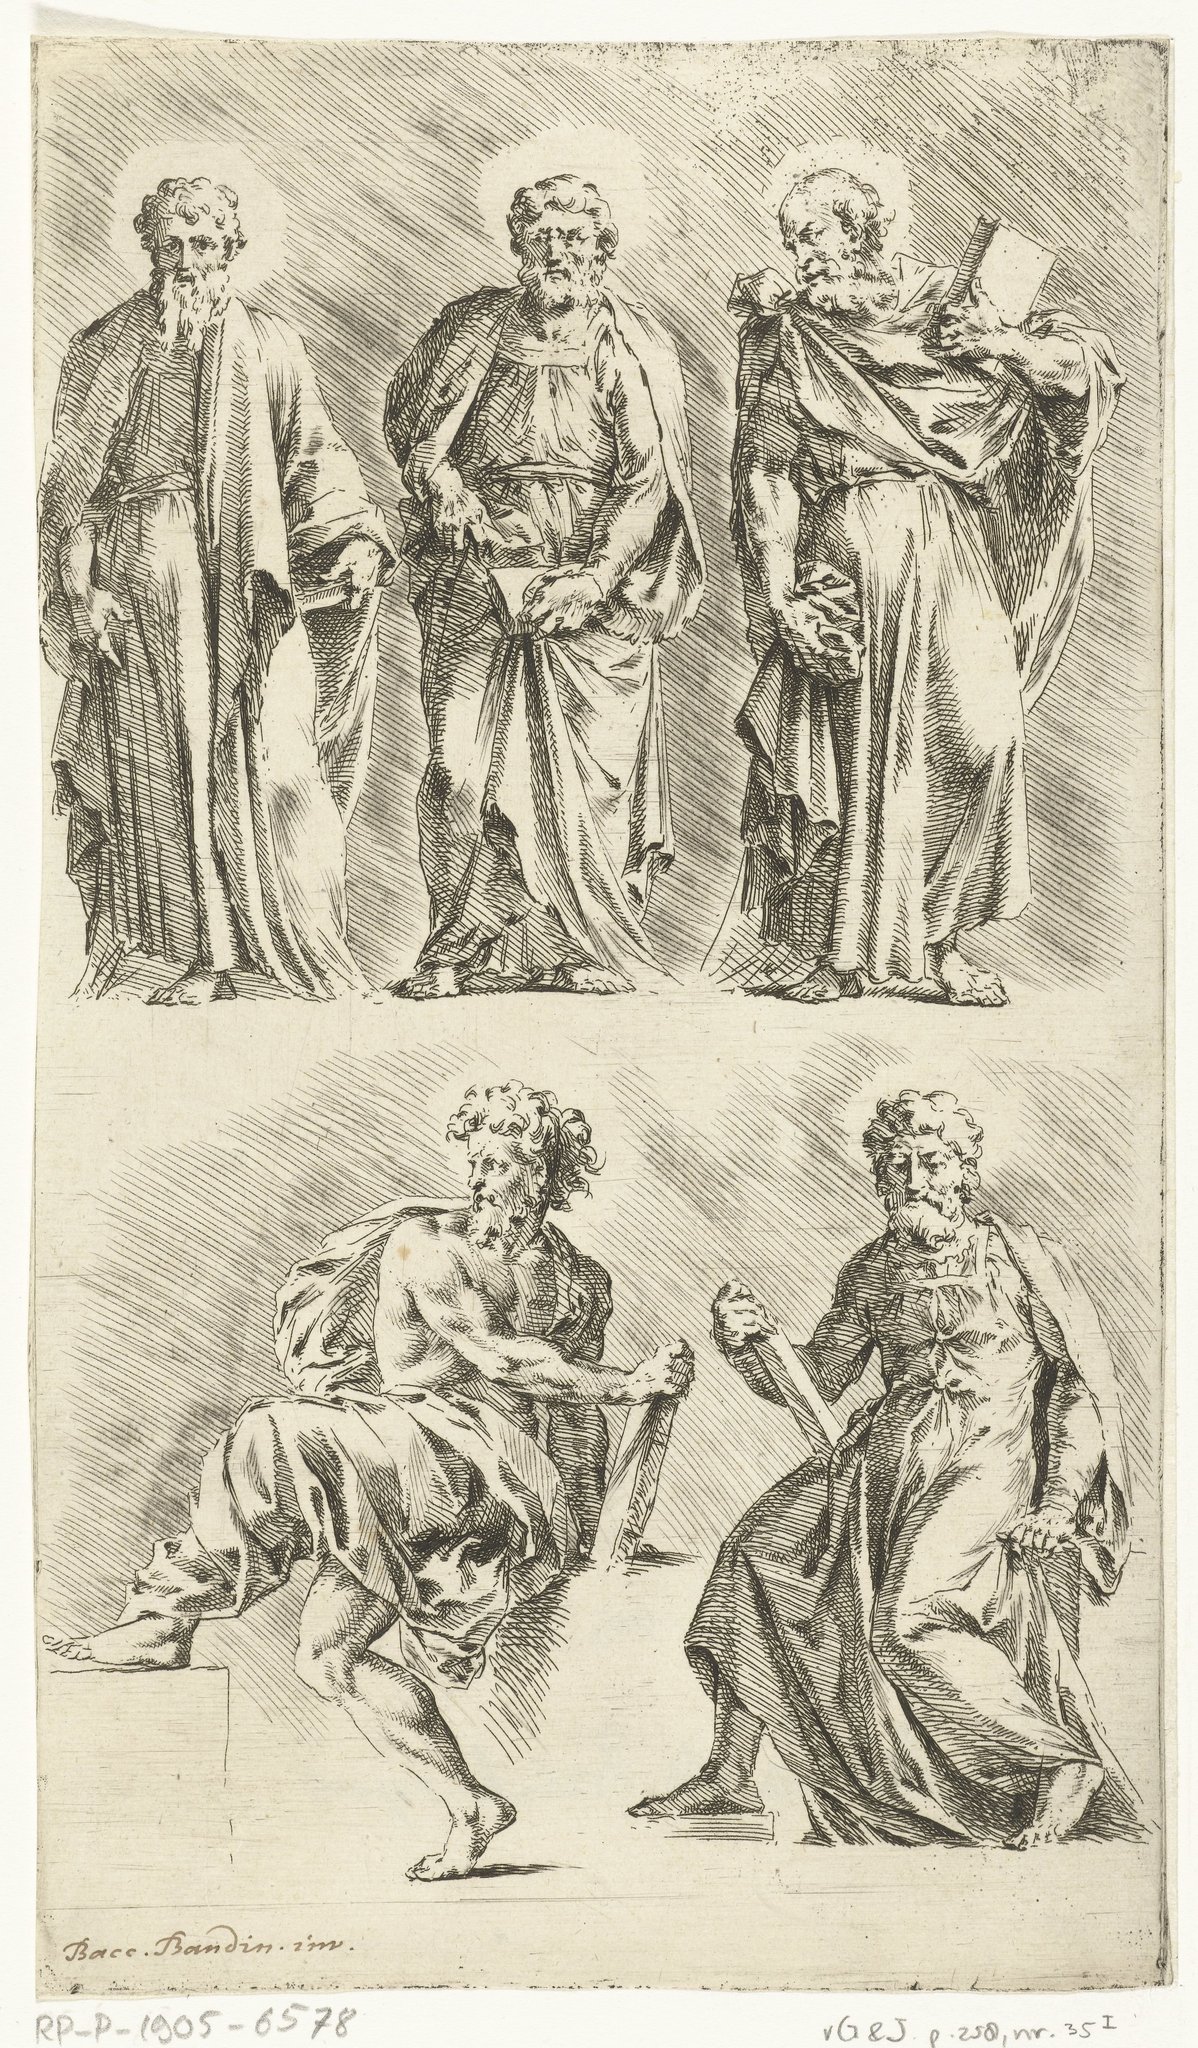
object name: print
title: Vijf heiligen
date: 1668-1671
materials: paper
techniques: etching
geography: northern netherlands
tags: saints, other groups of apostles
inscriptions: collector's mark: Lugt 2228, signature: ‘Bacc. Bandin. inv.’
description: afkomstig uit: Paradigmata graphices variorum artificum : voor-beelden der teken-konst van verscheyde meesters, (2e of latere editie)